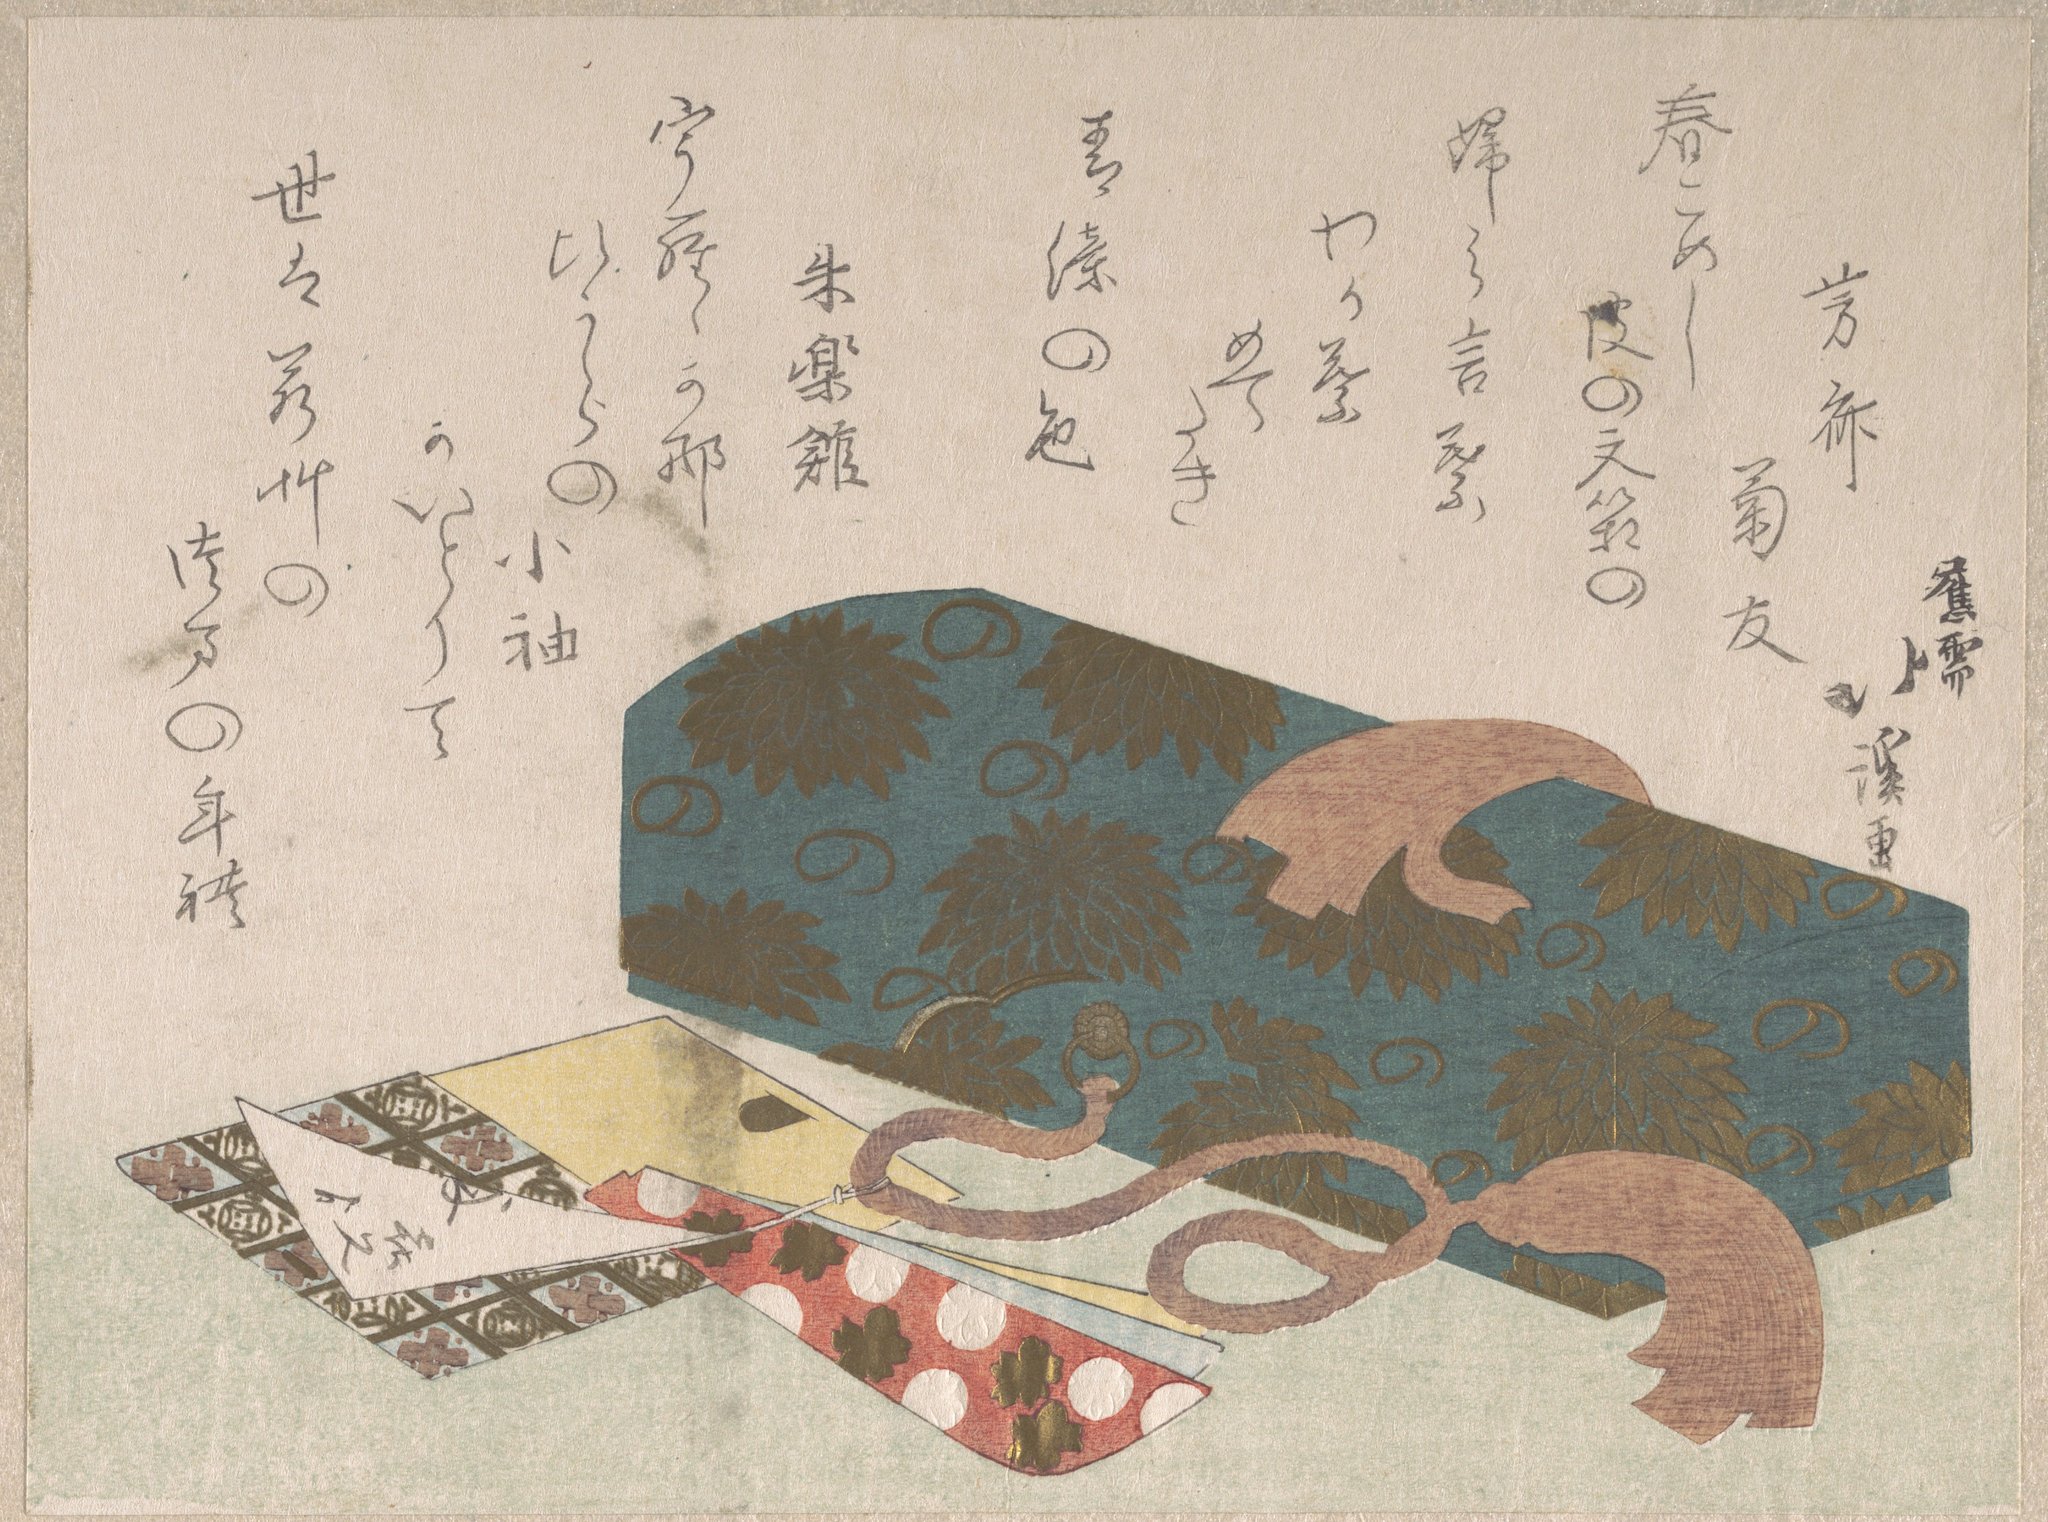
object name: woodblock print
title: Letter-box and Toothpick Holders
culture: japanese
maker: totoya hokkei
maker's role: artist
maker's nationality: japanese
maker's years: 1780-1850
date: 1801-1900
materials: ink, paper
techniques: surimono, woodblock print